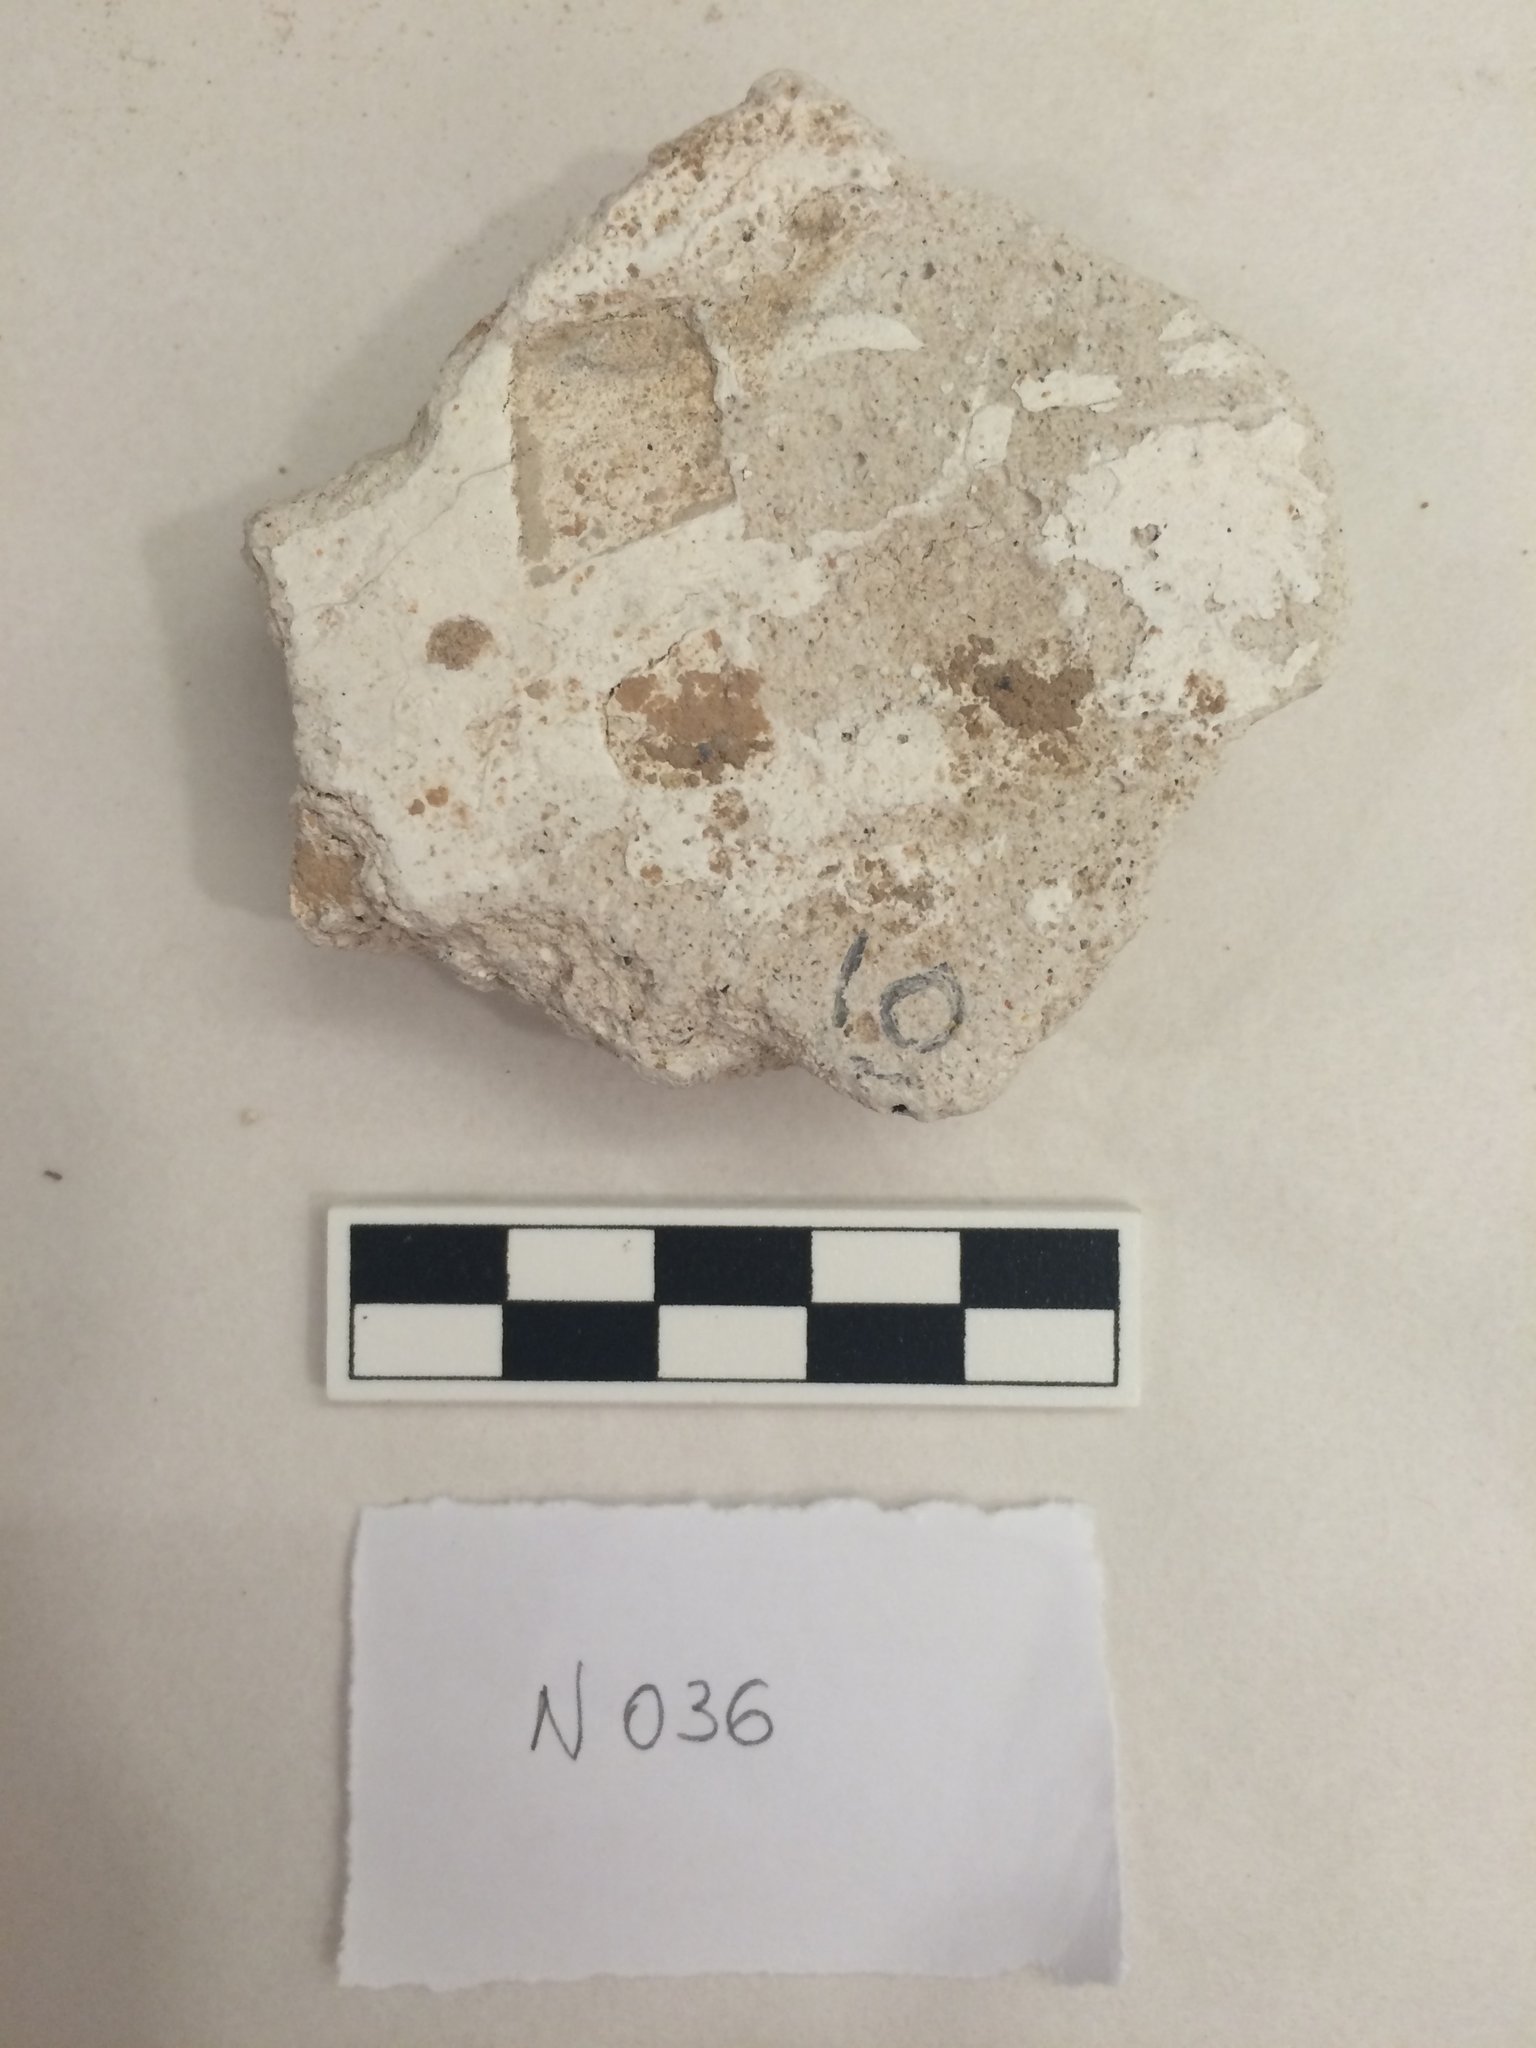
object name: fragment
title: Stucco Fragment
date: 701-1200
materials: plaster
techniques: carving, painting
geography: iran